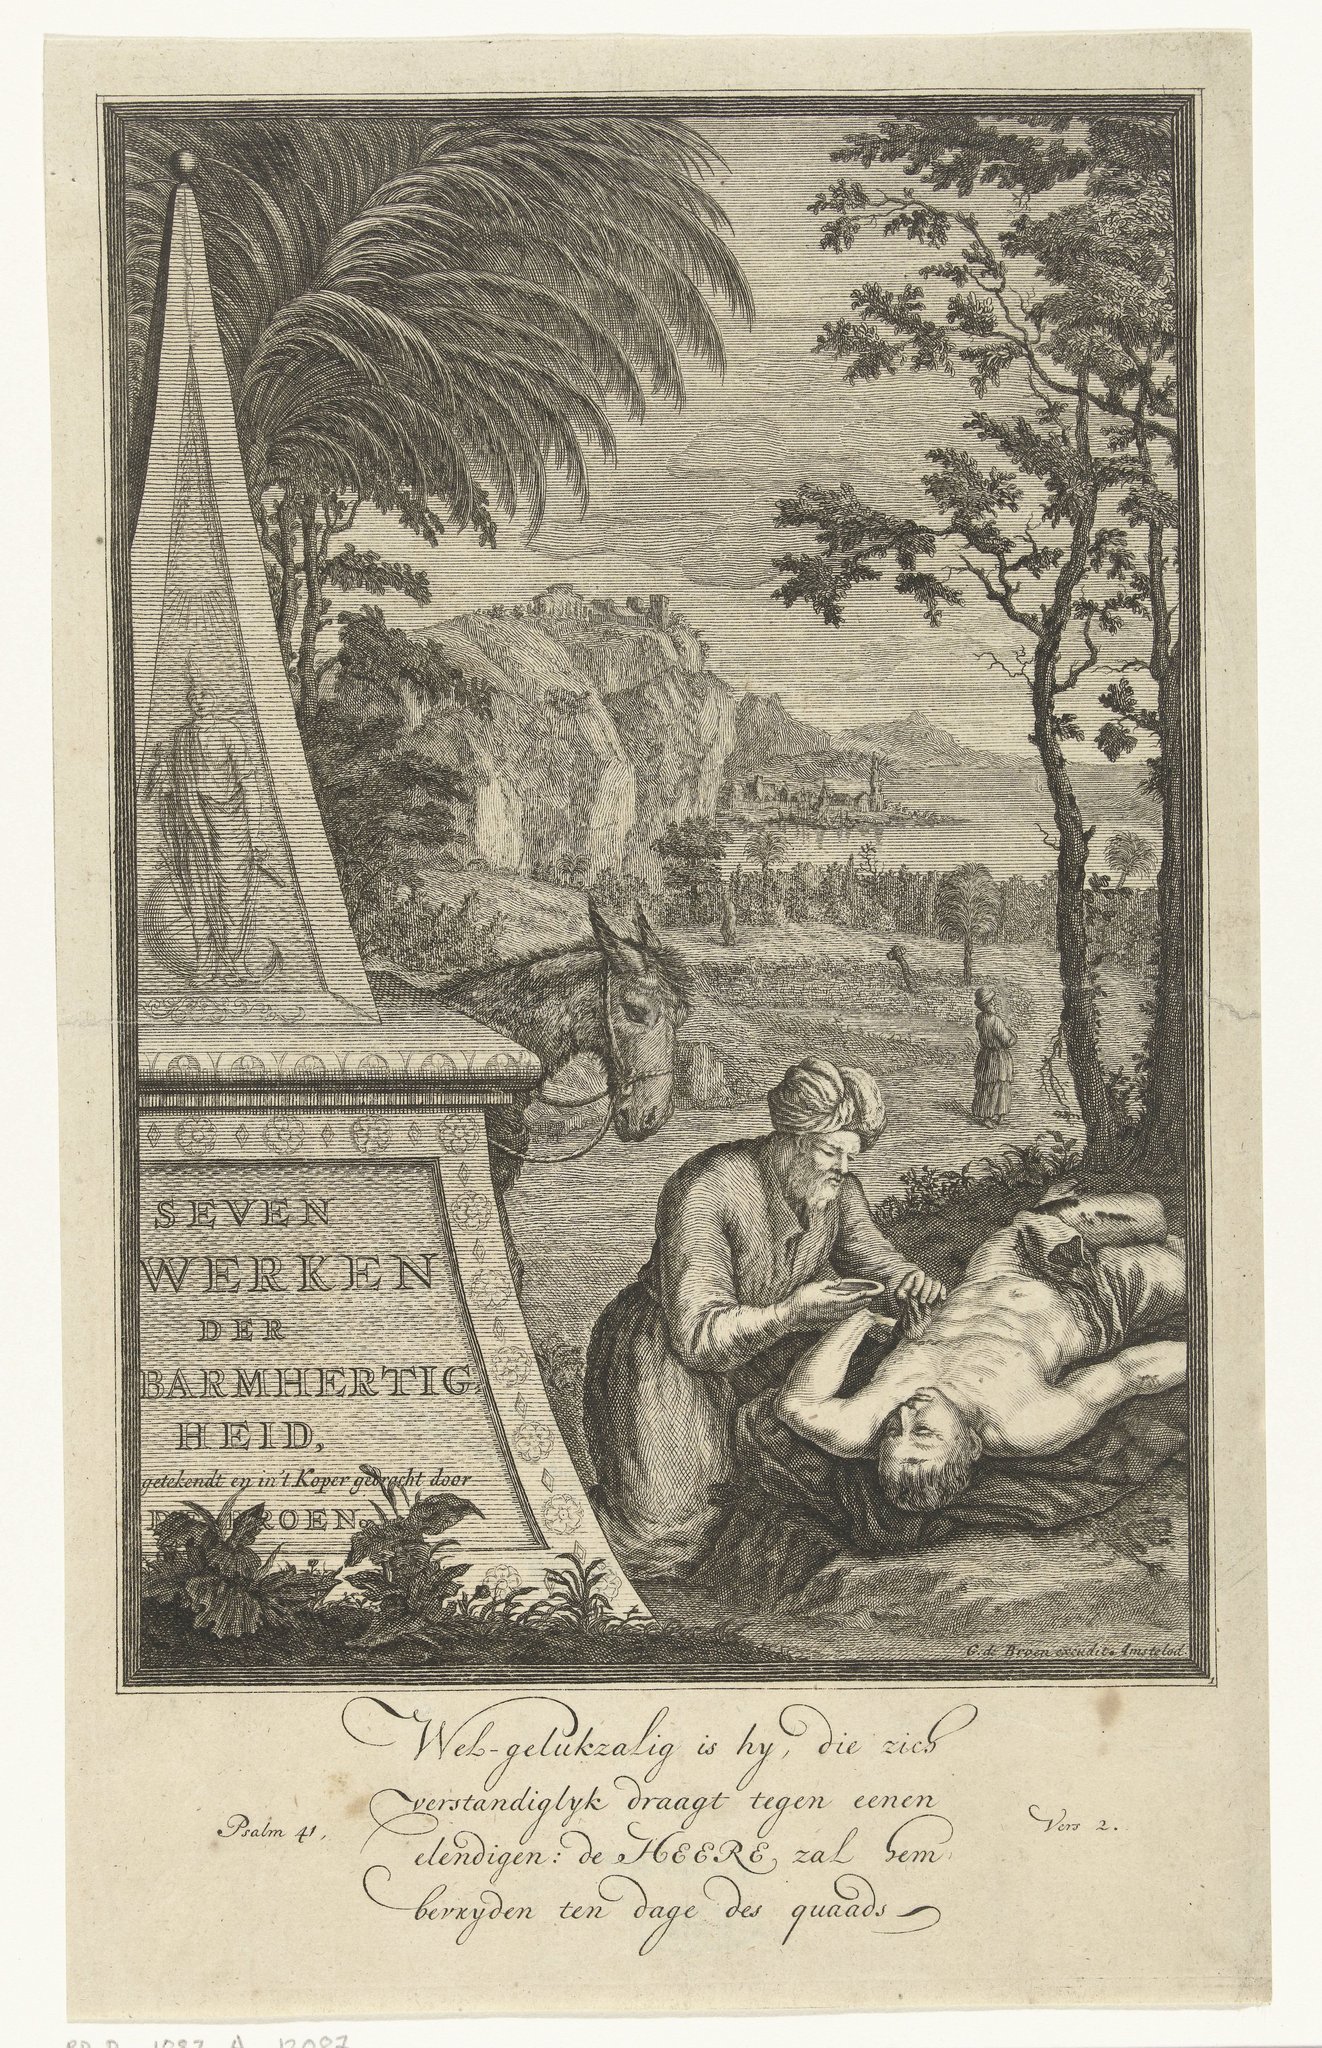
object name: titelprent, frontispice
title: Zeven werken van barmhartigheid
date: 1695-1740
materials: paper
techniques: engraving, etching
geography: amsterdam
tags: a samaritan tending the wounds of the traveller, the (seven) acts of mercy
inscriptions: collector's mark: Lugt 2228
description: Titelprent voor een prentserie met de werken der barmhartigheid. De barmhartige Samaritaan verzorgt de gewonde reiziger die langs de weg ligt. Met een doekje dept hij zijn wonden. Op de achtergrond is de priester te zien die de gewonde man niet hielp en doorliep.